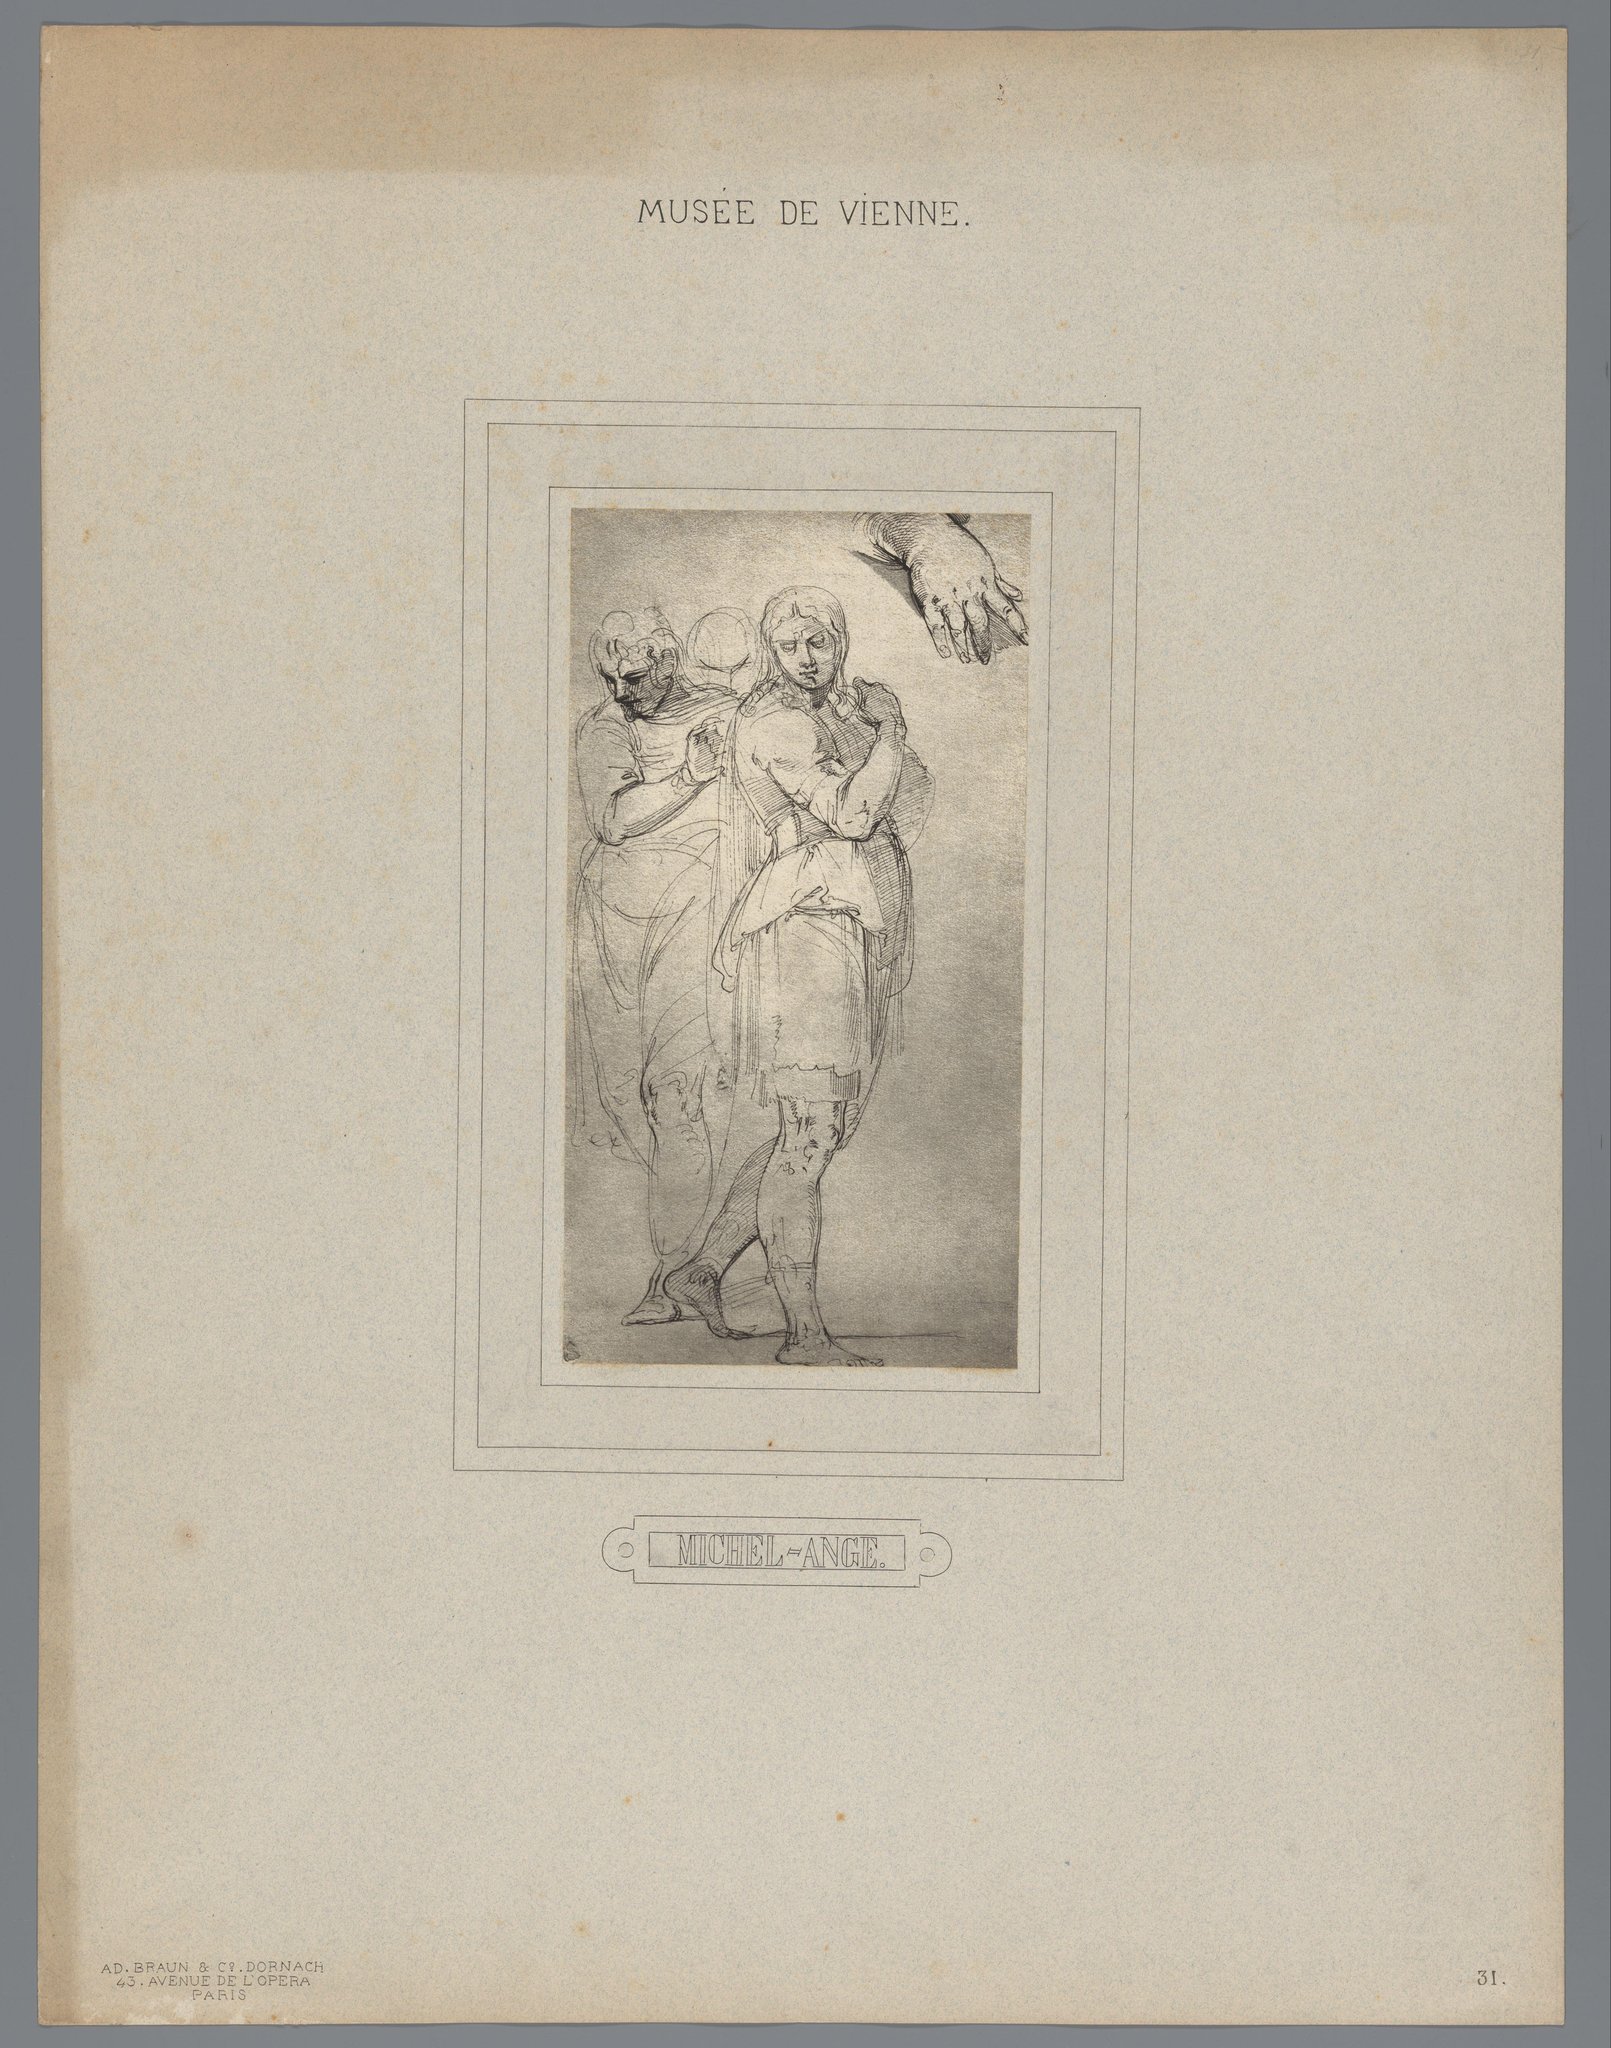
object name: photograph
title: Fotoreproductie van een tekening van Michelangelo (figuurstudie)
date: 1880-1900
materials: cardboard, paper, photographic support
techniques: carbon print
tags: rome, painter, draughtsman, michelangelo